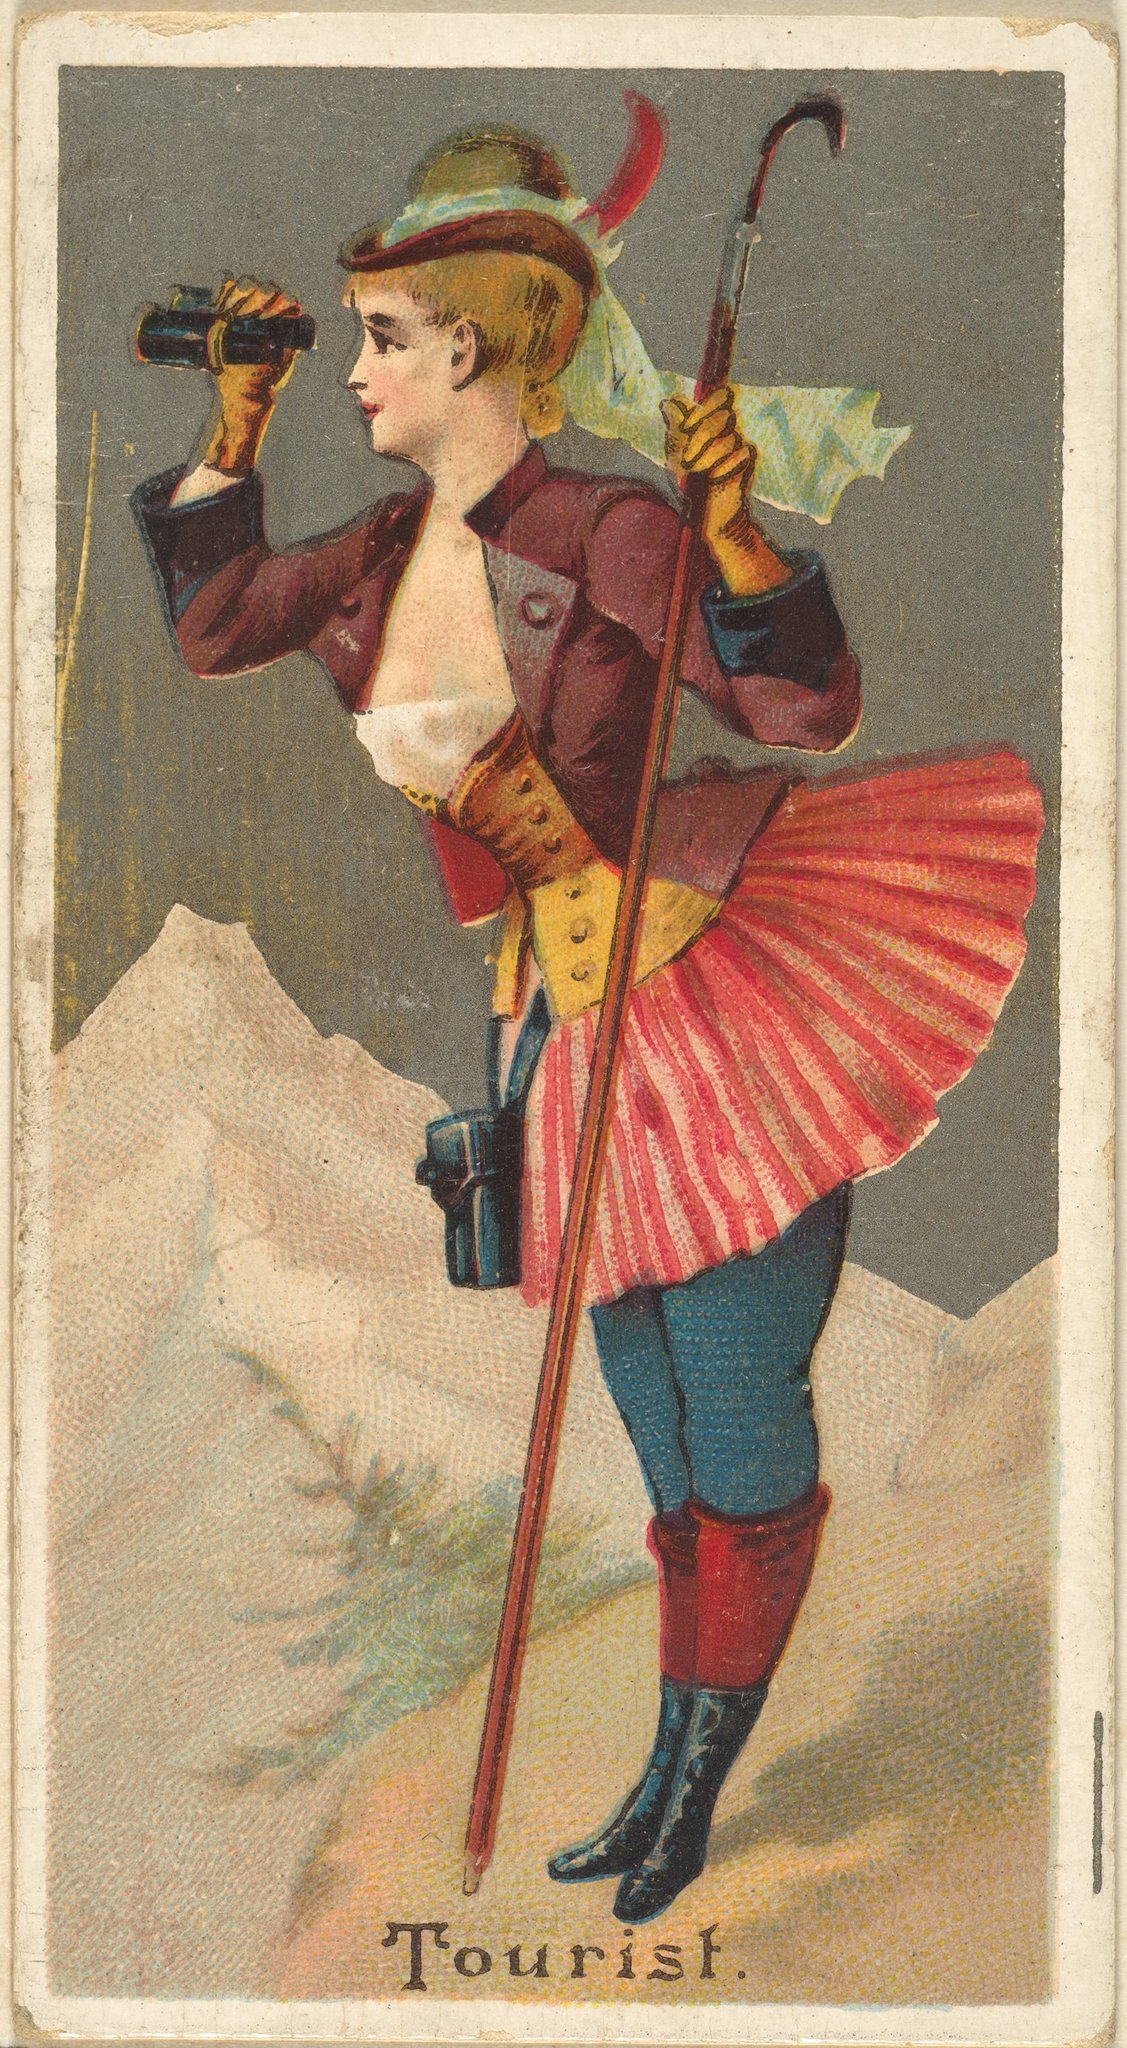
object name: print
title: Tourist, from the Occupations for Women series (N166) for Old Judge and Dogs Head Cigarettes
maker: goodwin & company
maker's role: publisher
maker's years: 1850-1950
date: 1887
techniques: color lithograph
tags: women